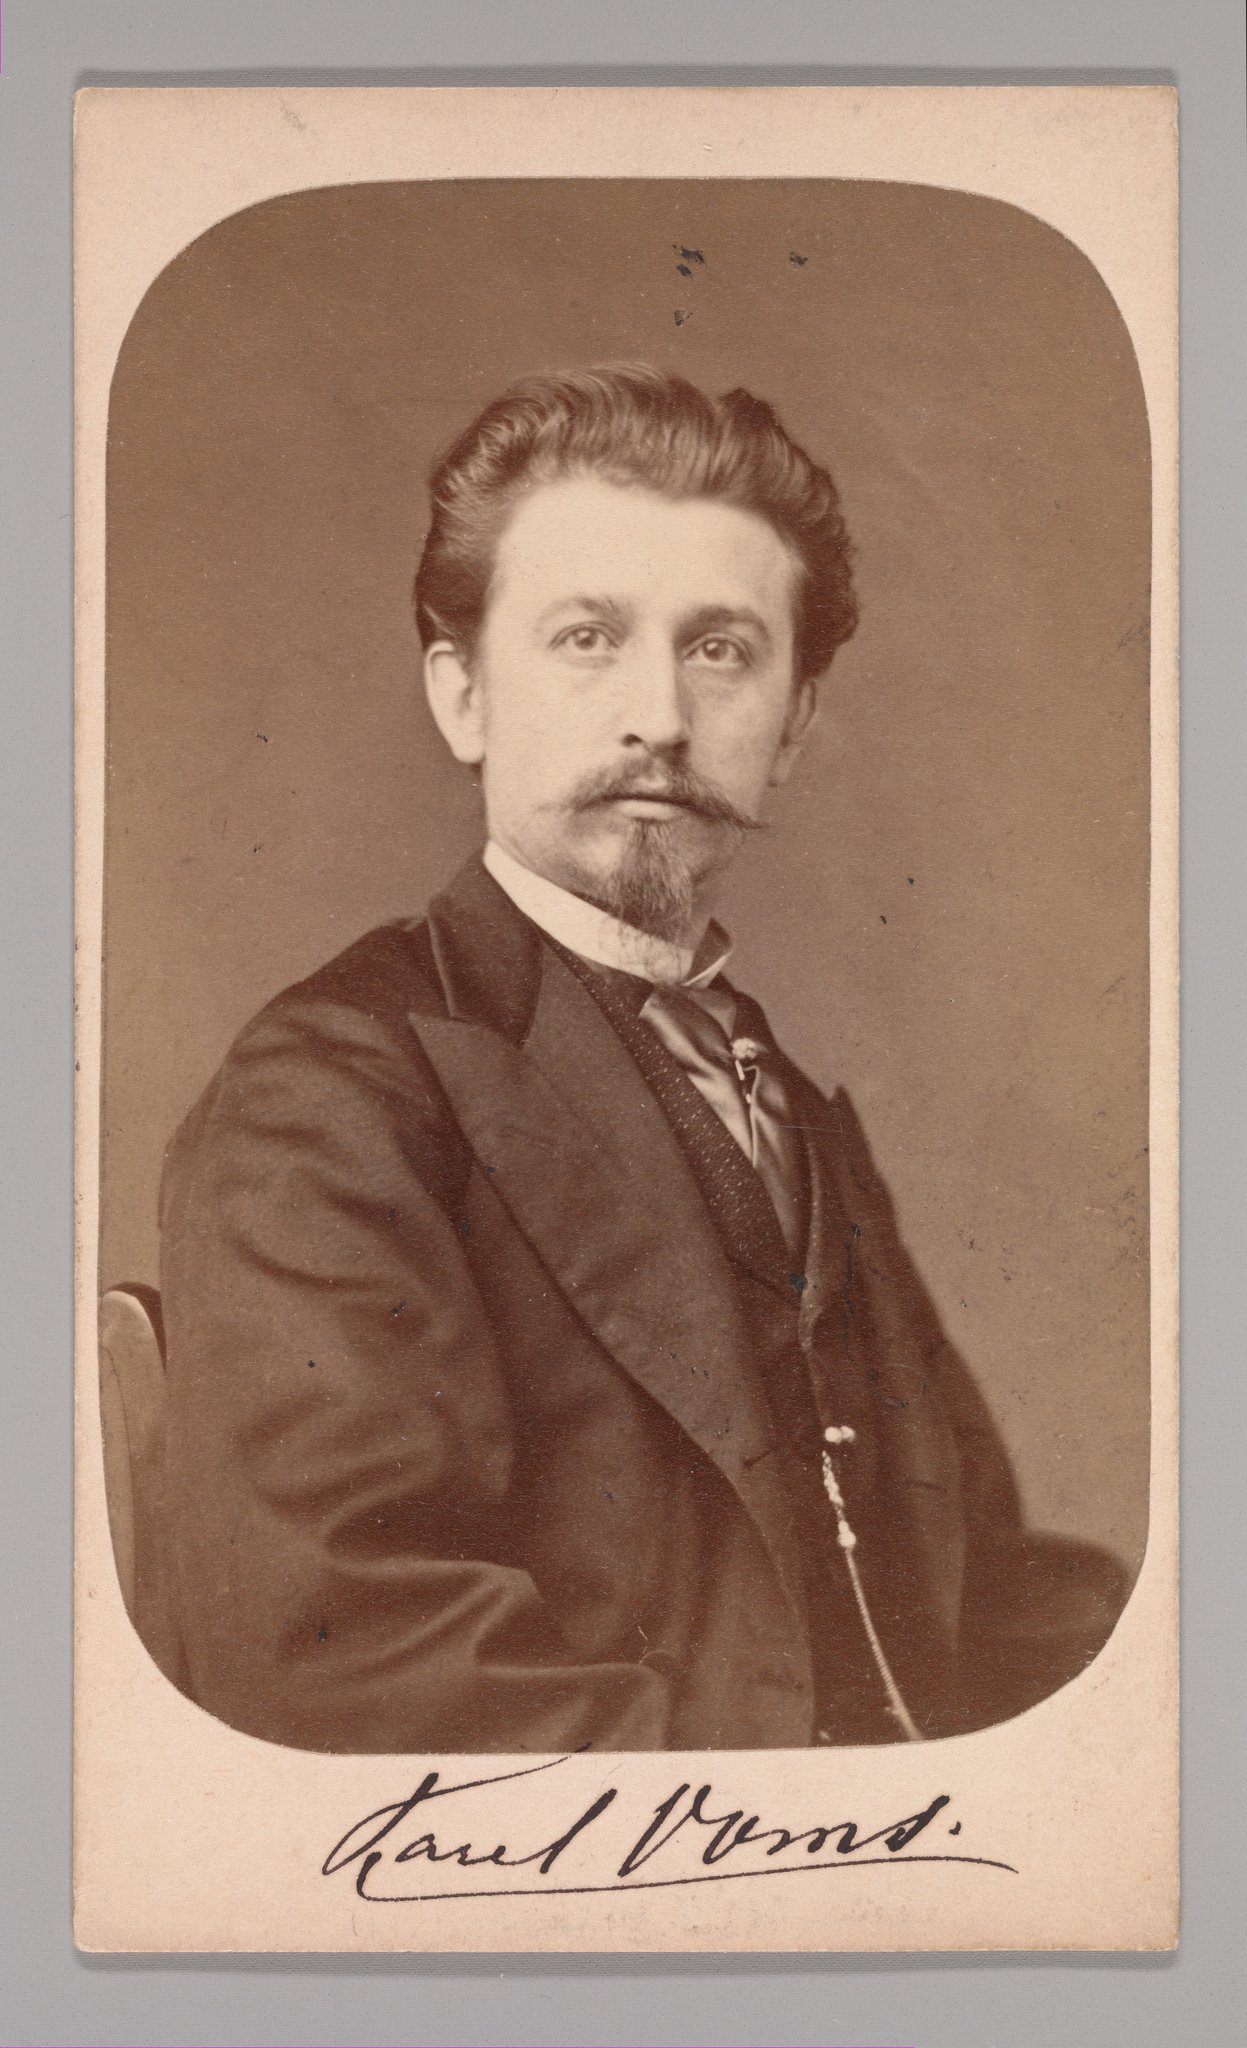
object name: carte de visite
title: [Karel Ooms]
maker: Anonymous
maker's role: artist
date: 1860-1869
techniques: albumen silver print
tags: men,portraits